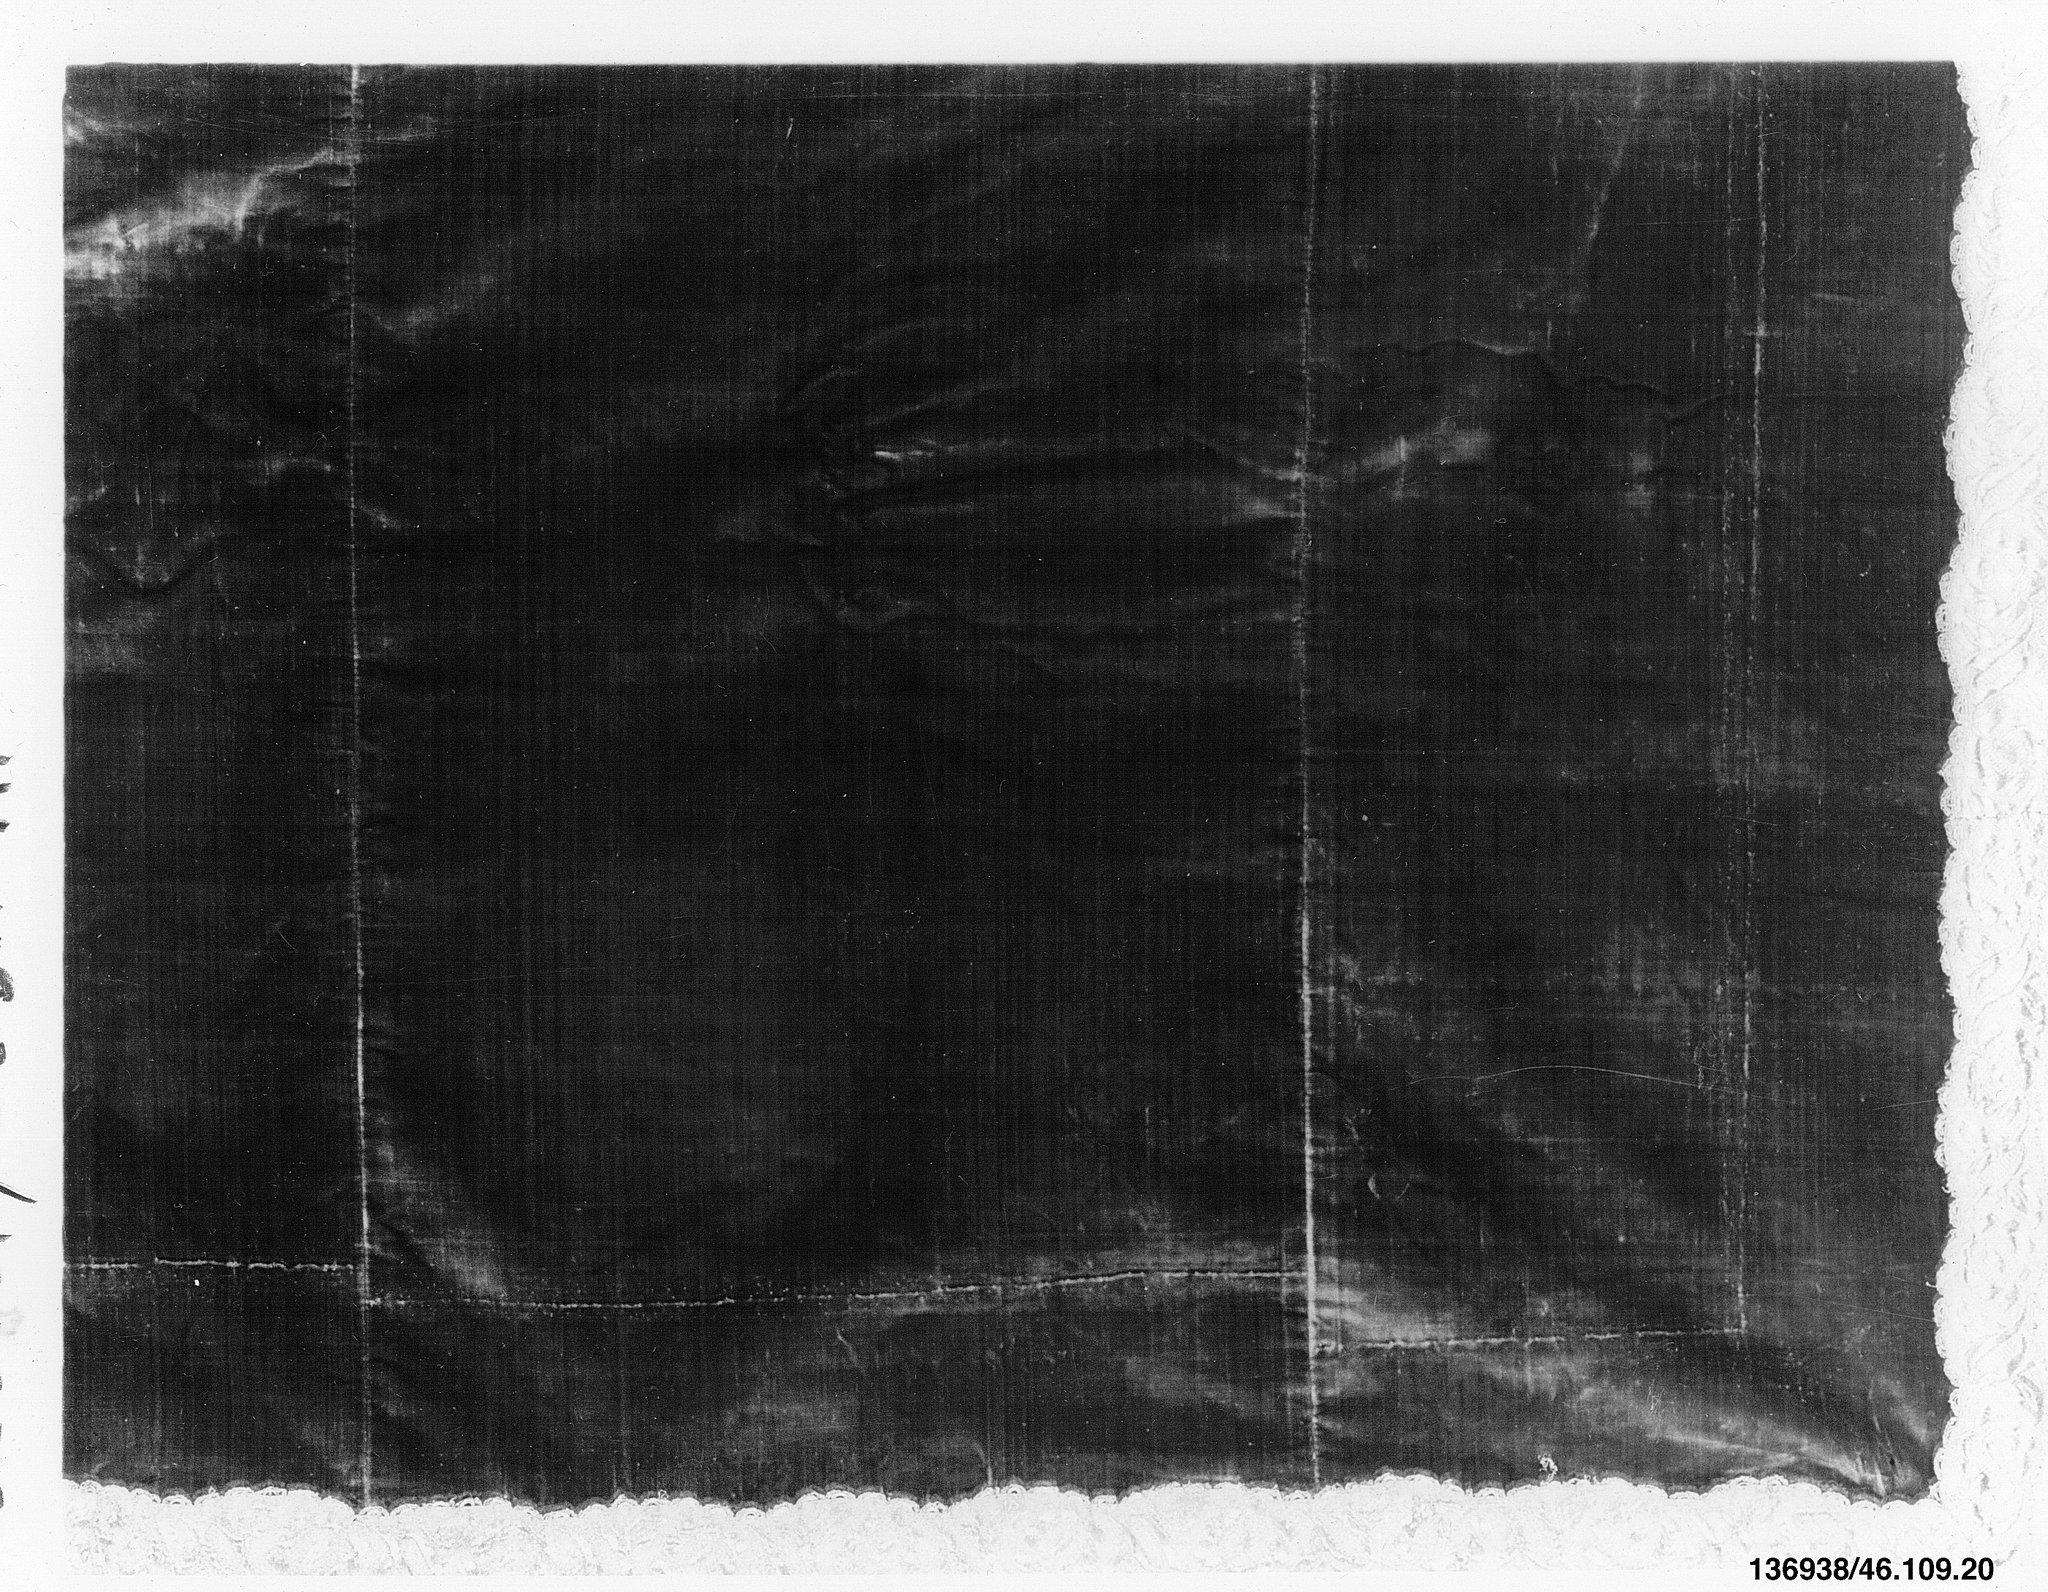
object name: piece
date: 1701-1733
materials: silk